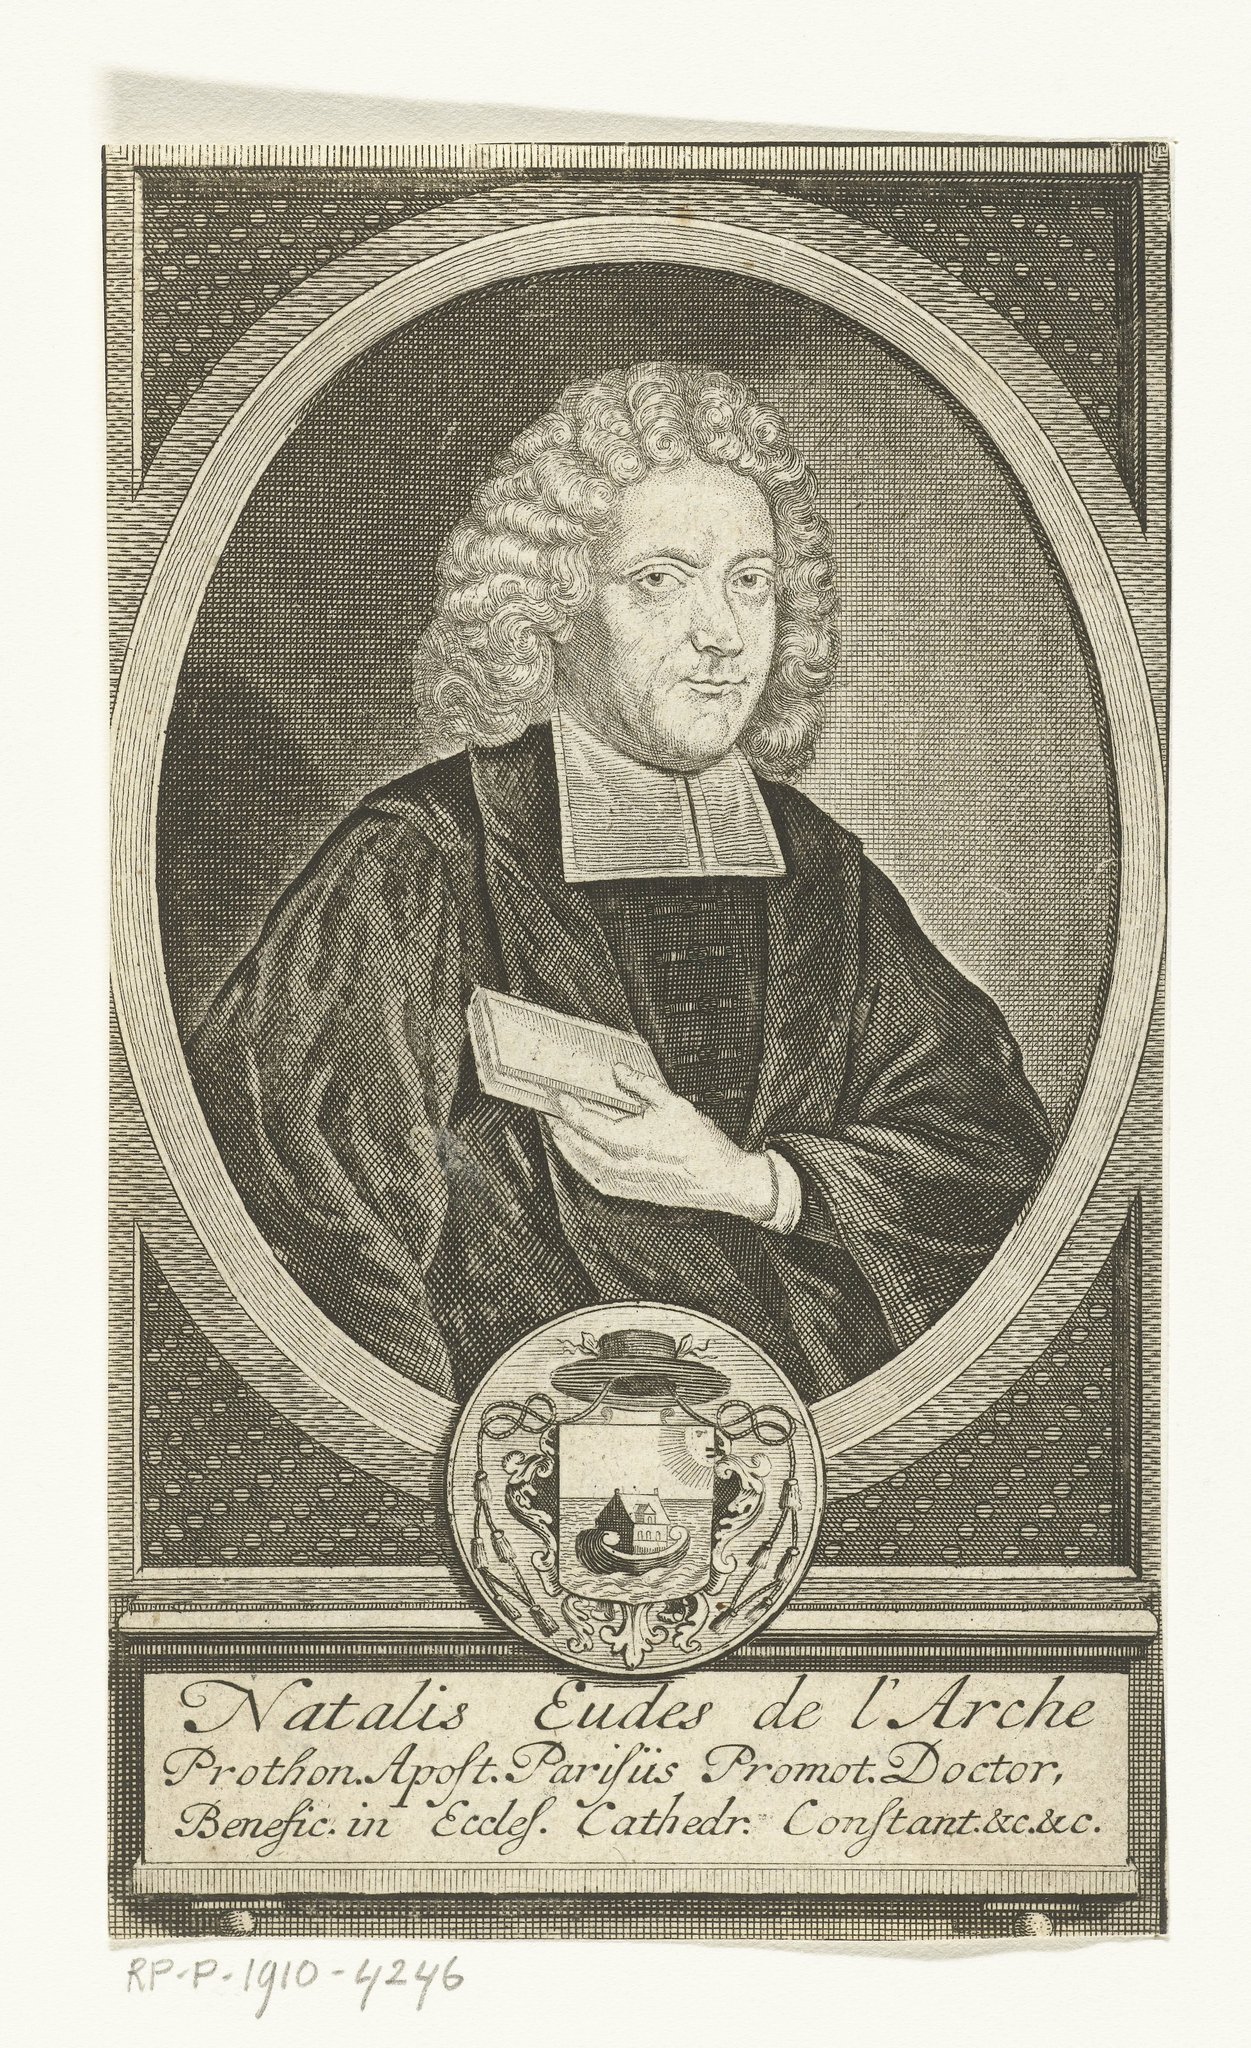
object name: print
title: Natalis Eudes de l'Arche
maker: reynier blokhuysen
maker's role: print maker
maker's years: 1663-1744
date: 1673-1744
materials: paper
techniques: etching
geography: netherlands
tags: predikant, natalis eudes l'arche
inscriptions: collector's mark: Lugt 2228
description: Portret van Natalis Eudes de l'Arche in ovale omlijsting met zijn wapen en zijn titel op een console.